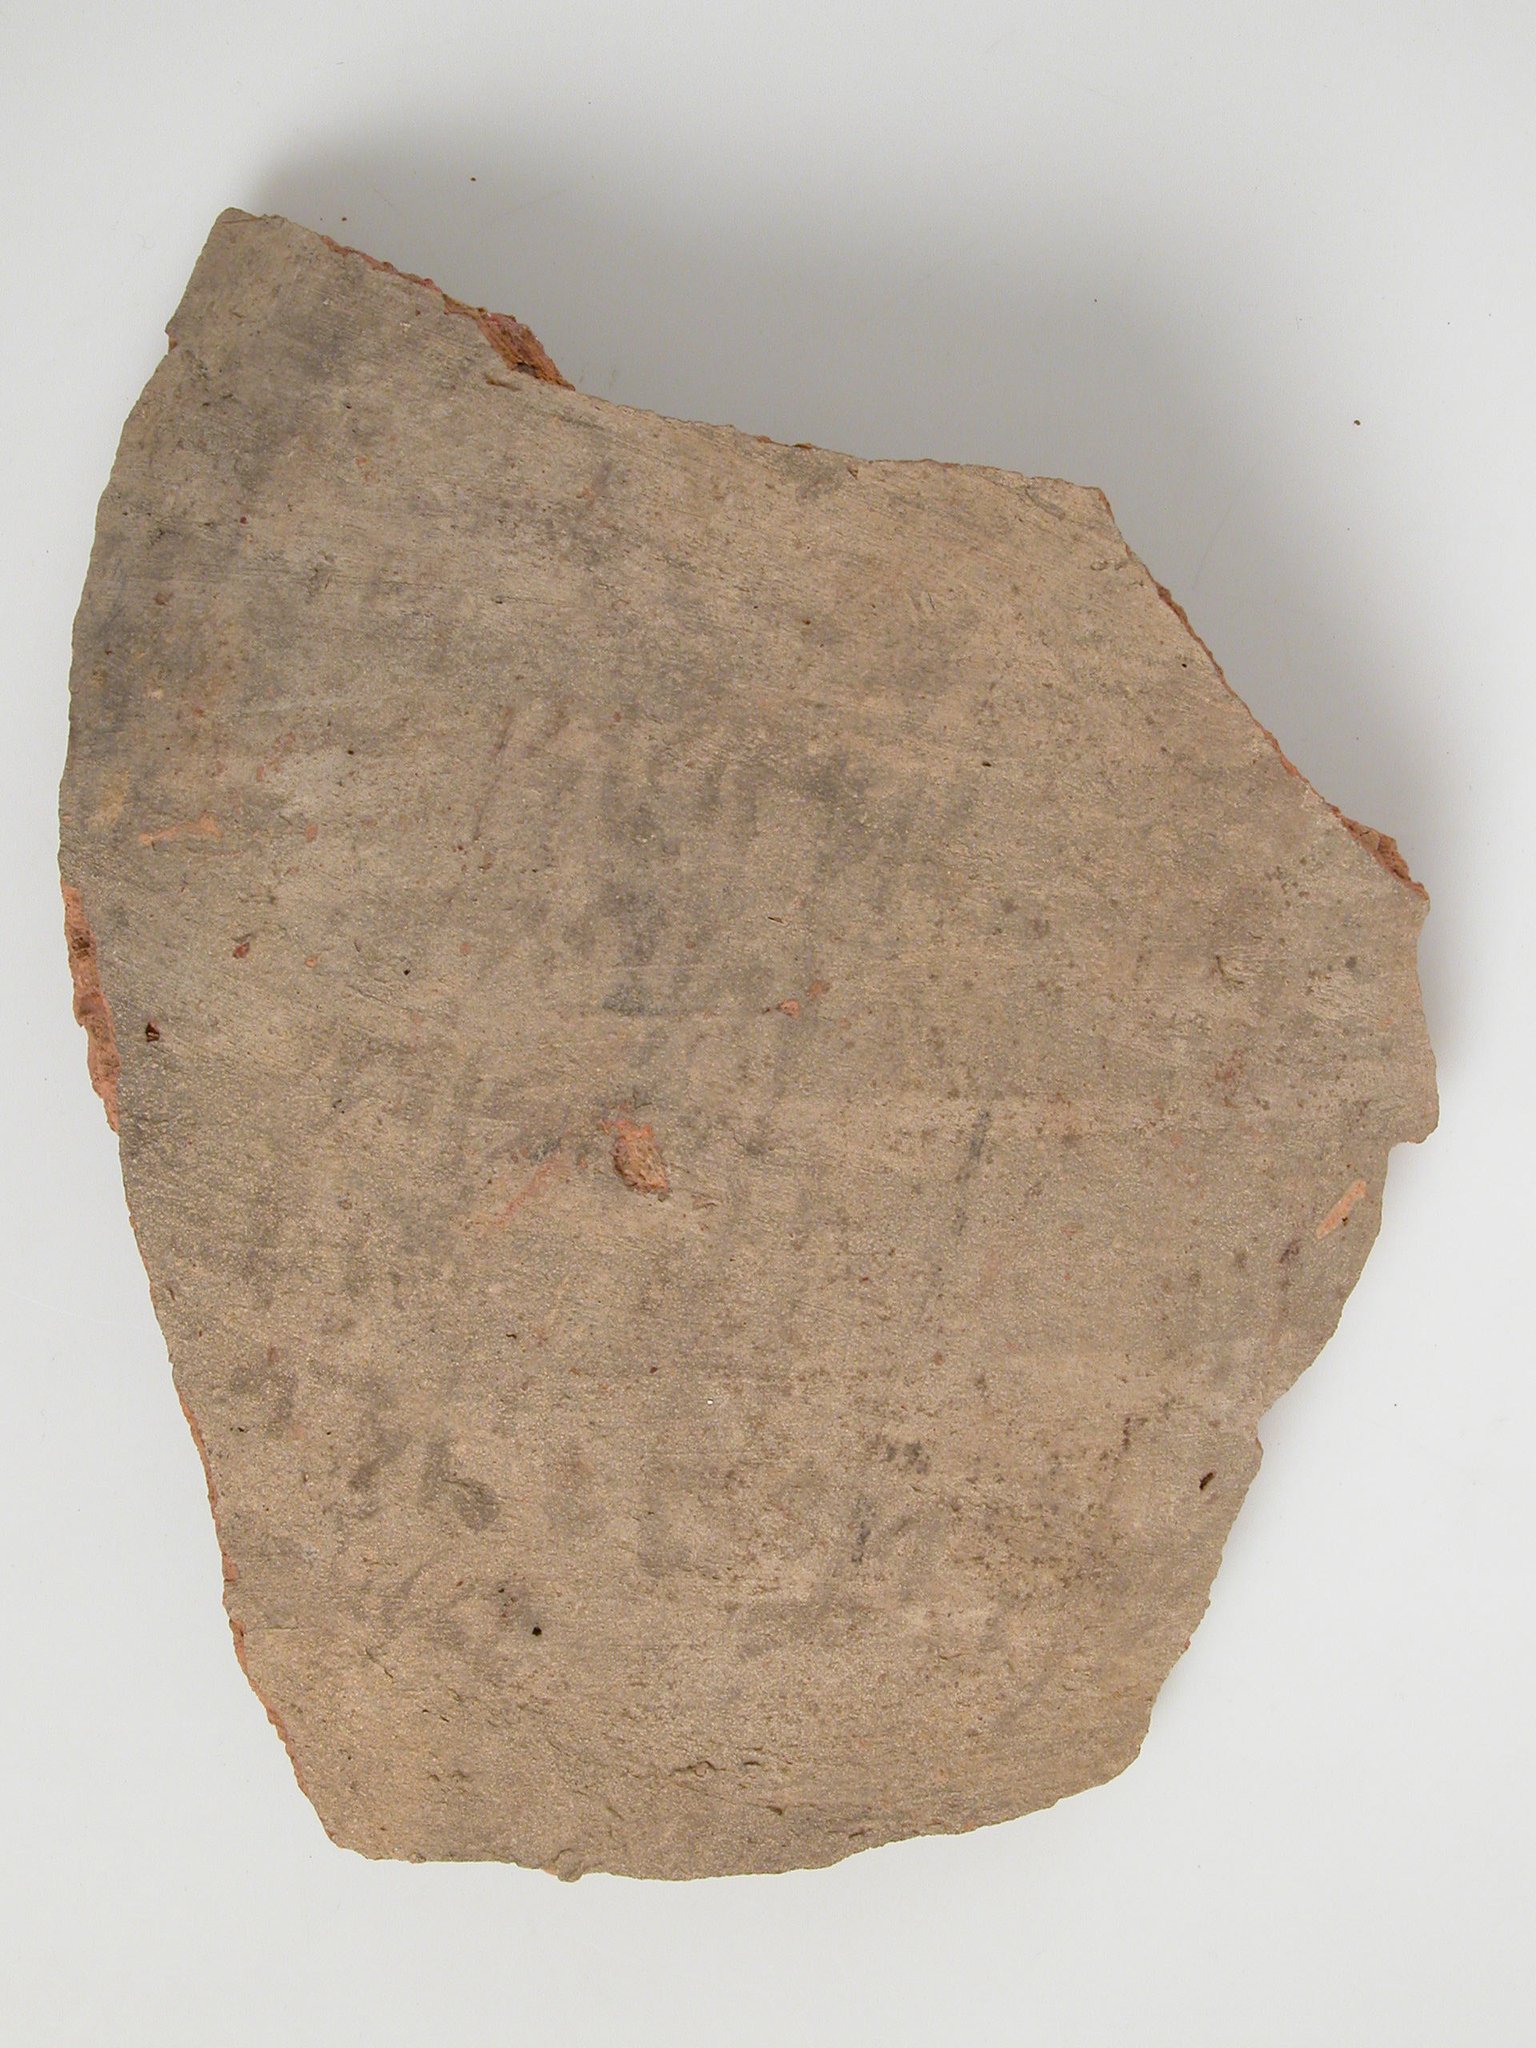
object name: ostracon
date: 400-30 BCE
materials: ink, pottery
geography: egypt